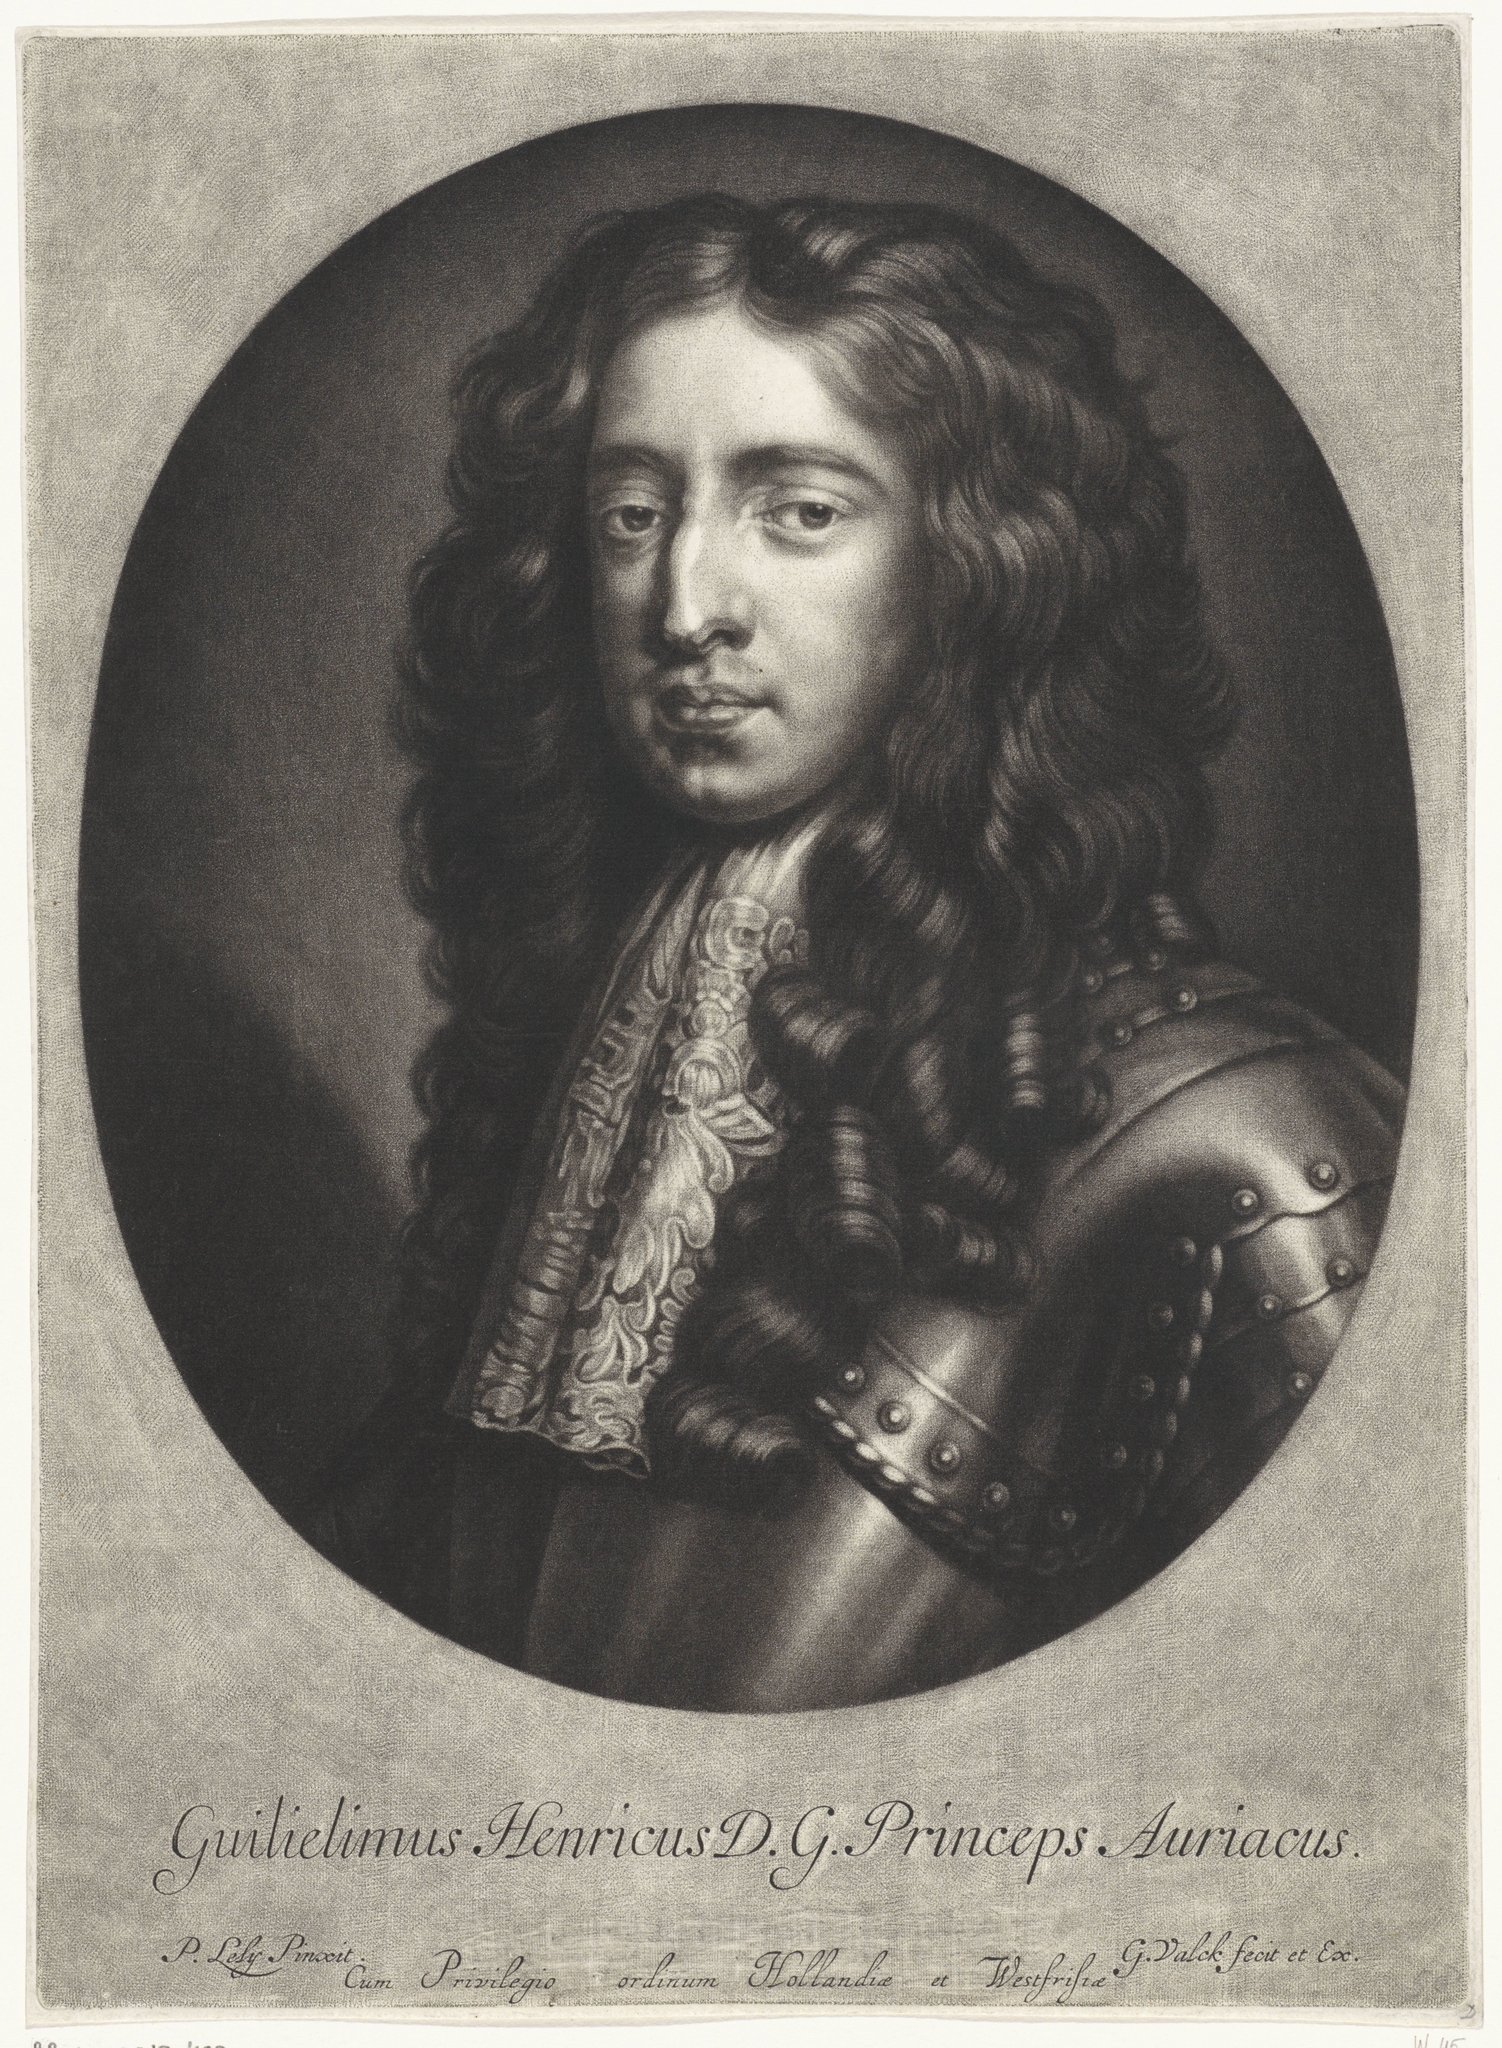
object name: print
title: Portret van Willem III, prins van Oranje-Nassau, koning van Engeland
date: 1662-1726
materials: paper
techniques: mezzotint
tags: the hague, william iii (prince of orange and king of england, scotland, and ireland), armour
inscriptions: collector's mark: Lugt 963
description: Willem III, prins van Oranje-Nassau en sinds 1689 koning van Engeland. Hij draagt een harnas met een kraag van kant. In de marge een gedicht over het koningsschap in Engeland.